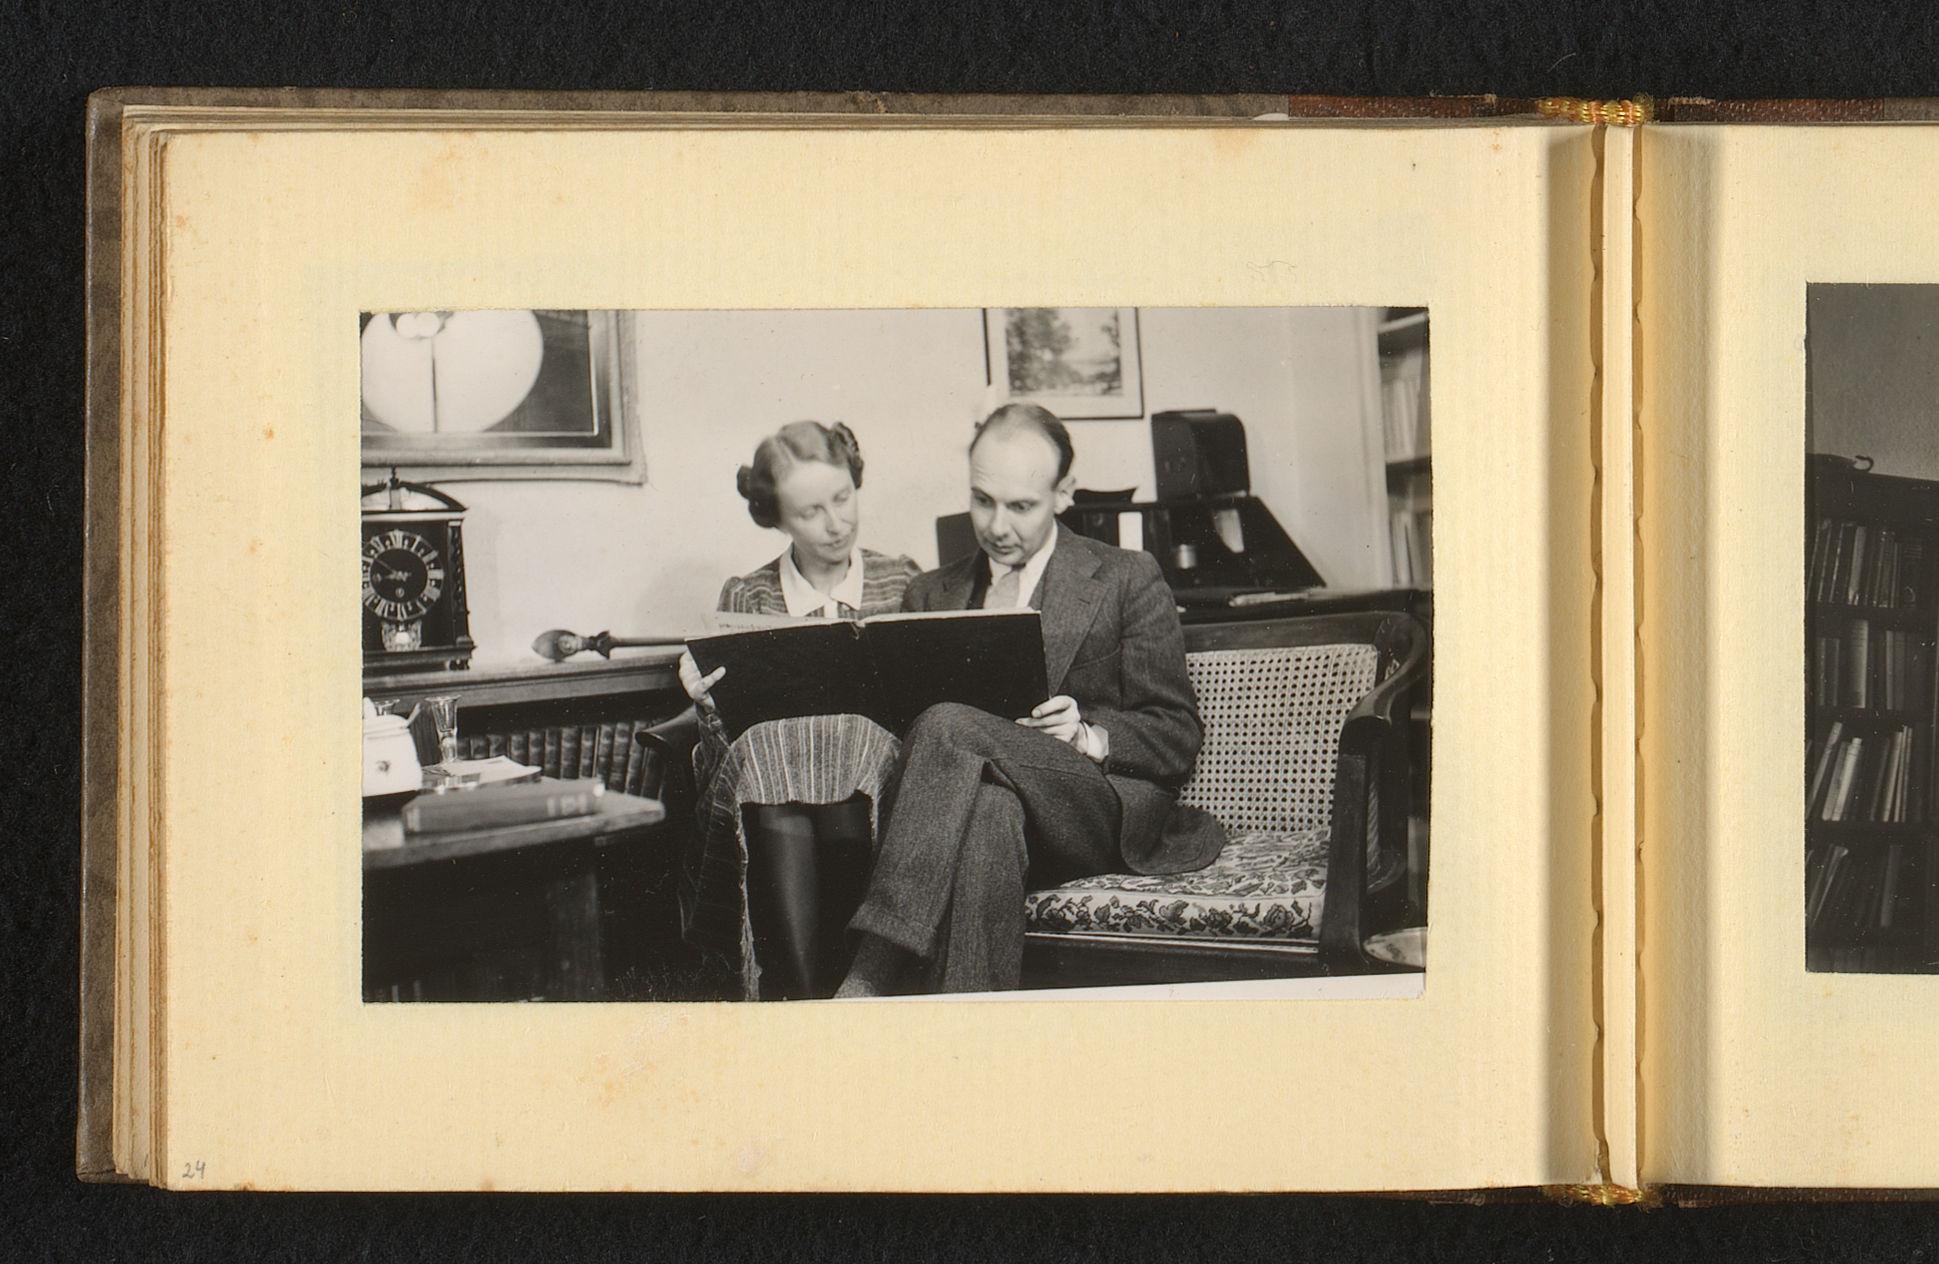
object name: album leaf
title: Vrouw en man bekijken een boek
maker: norbert van den berg (1901-1972)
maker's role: amateurfotograaf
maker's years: 1901-1972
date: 1935-1950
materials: paper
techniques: gelatin silver print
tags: adult woman, adult man, book